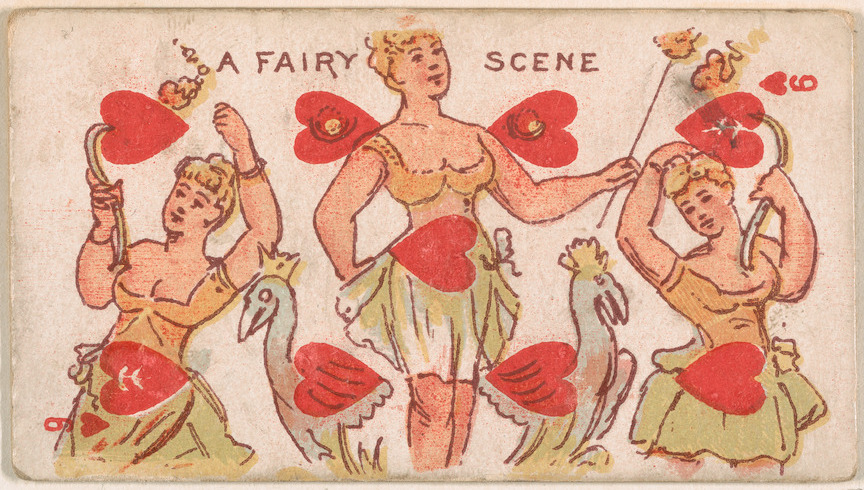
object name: print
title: Nine of Hearts, A Fairy Scene, from Harlequin Cards, 2nd Series (N220) issued by Kinney Bros.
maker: kinney brothers tobacco company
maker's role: publisher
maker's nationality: american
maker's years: 1869-2011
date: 1889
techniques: color lithograph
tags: playing cards